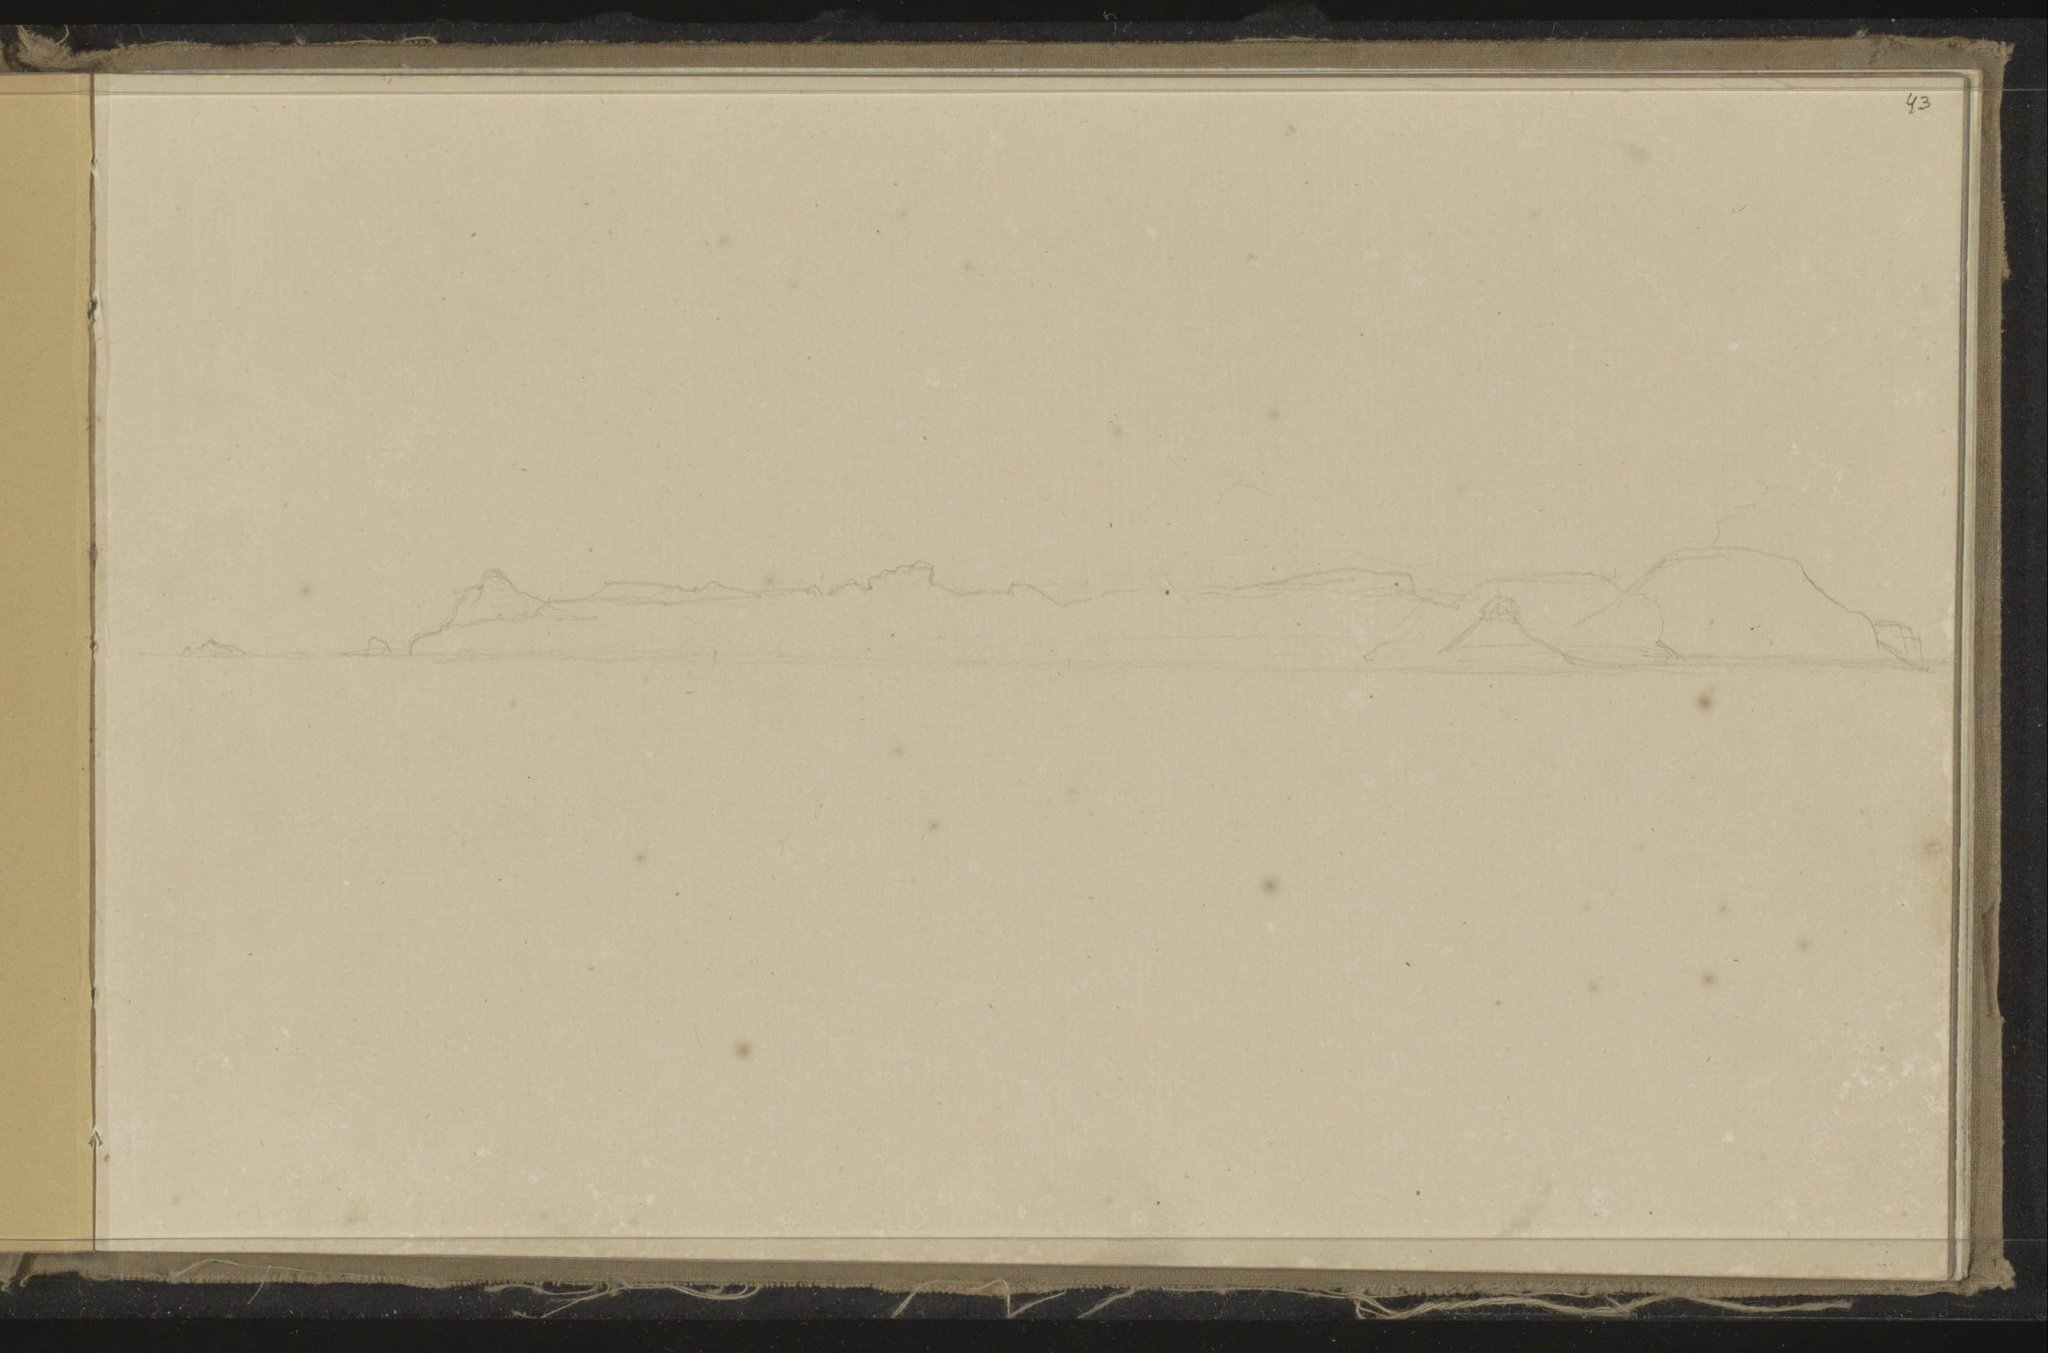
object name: sketchbook leaf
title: Gezicht op Sint-Helena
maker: christian heinrich gottlieb steuerwald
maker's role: draughtsman, print maker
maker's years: 1802-1874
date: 1848-1854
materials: paper, pencil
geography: sint-helena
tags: island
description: Blad 43 recto uit een schetsboek met 58 bladen.